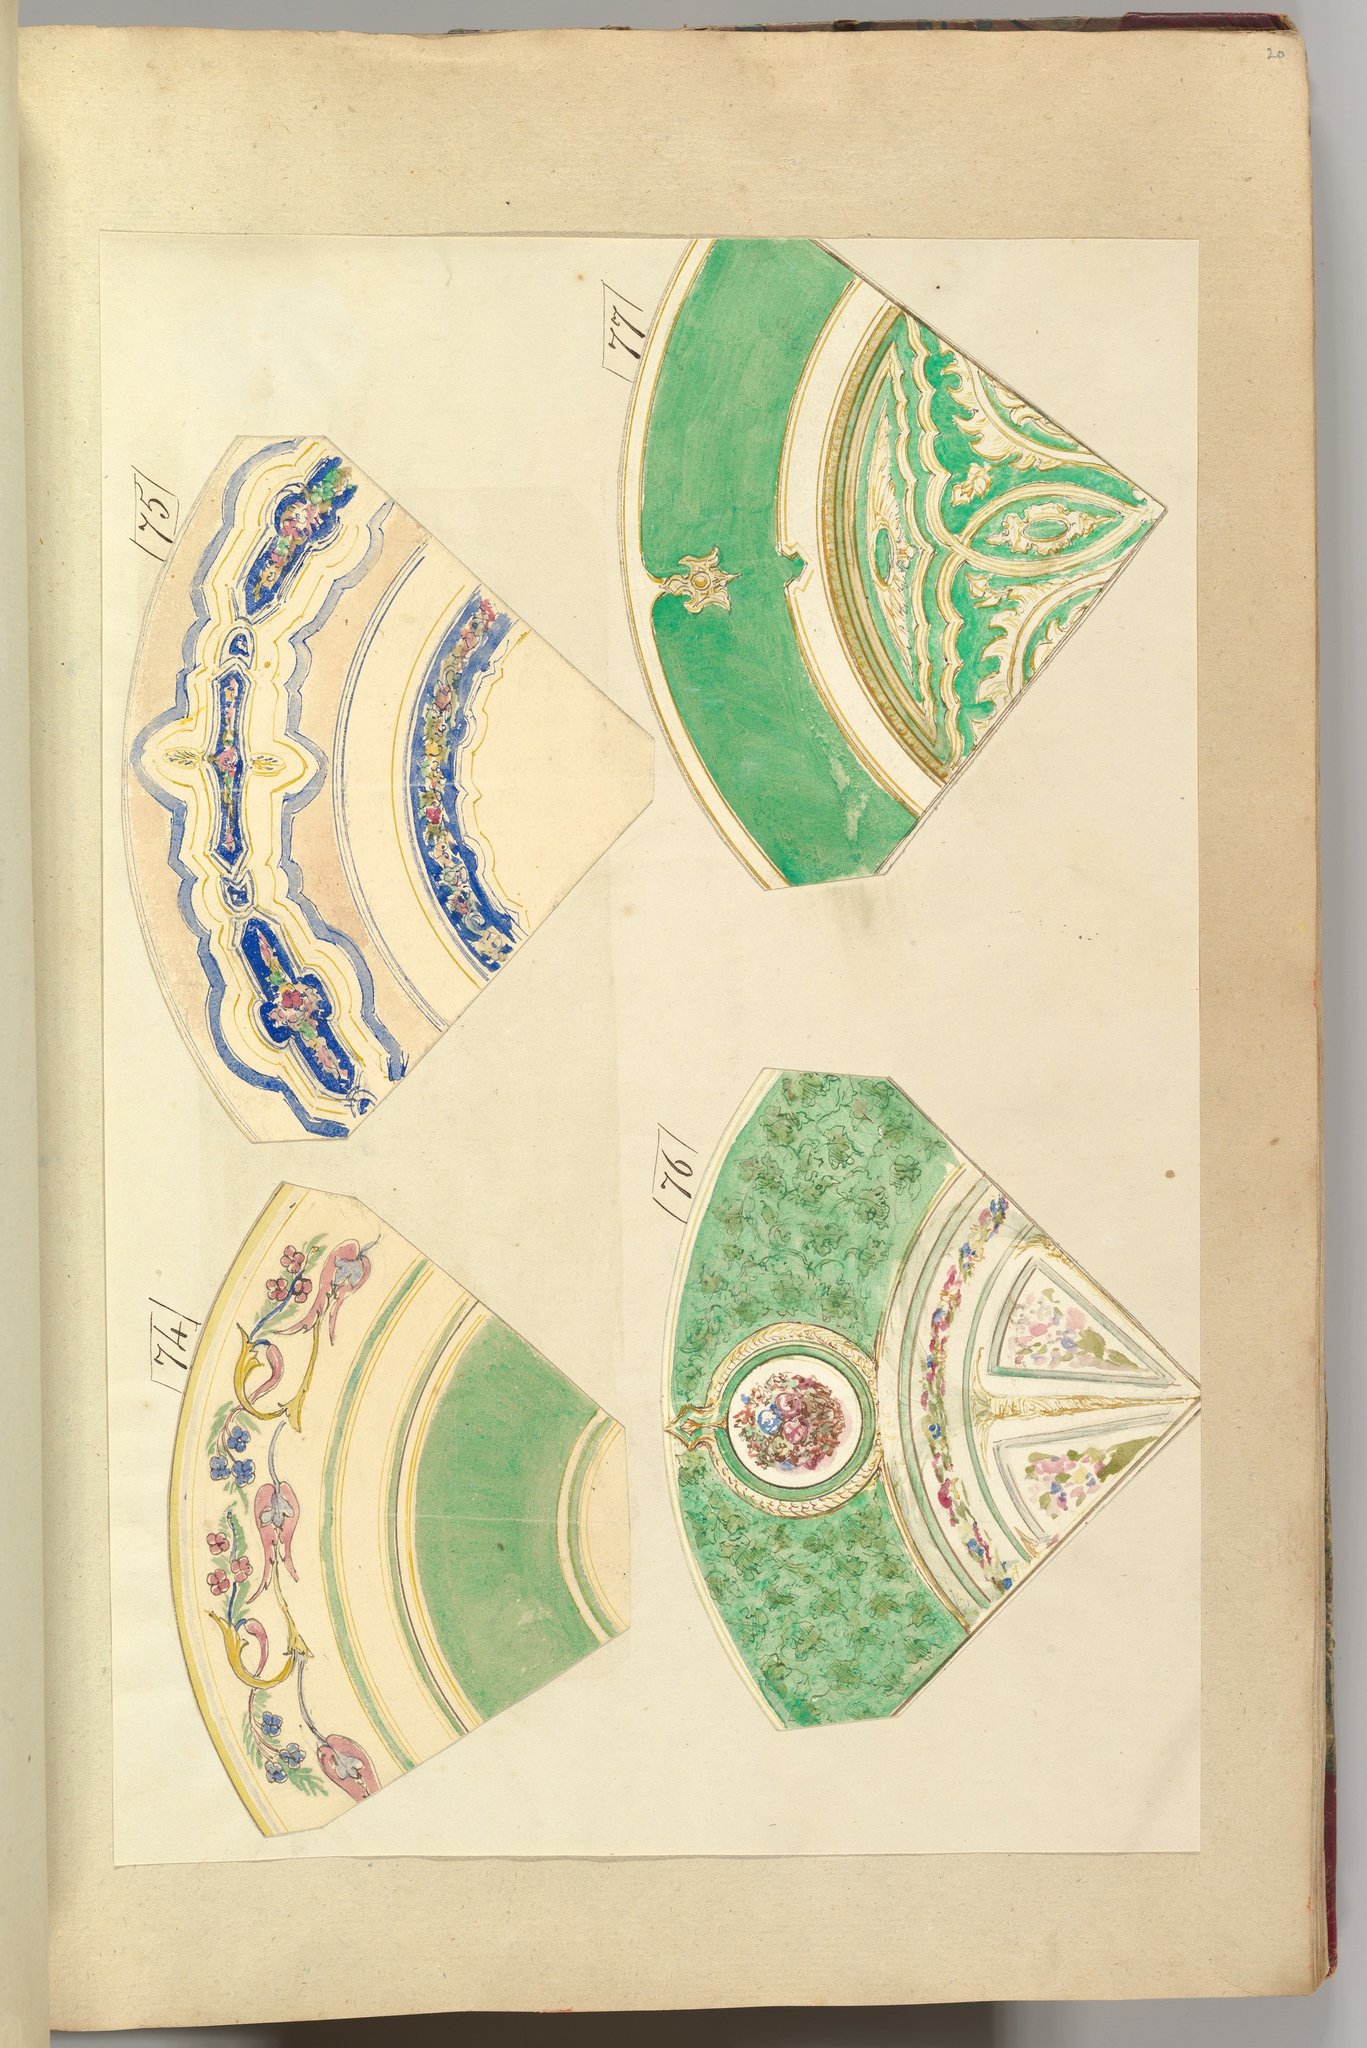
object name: drawing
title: Four Designs for Decorated Plates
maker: alfred henry forrester [alfred crowquill]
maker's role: artist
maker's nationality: british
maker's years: 1804-1872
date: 1845-1855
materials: ink, watercolor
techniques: pen